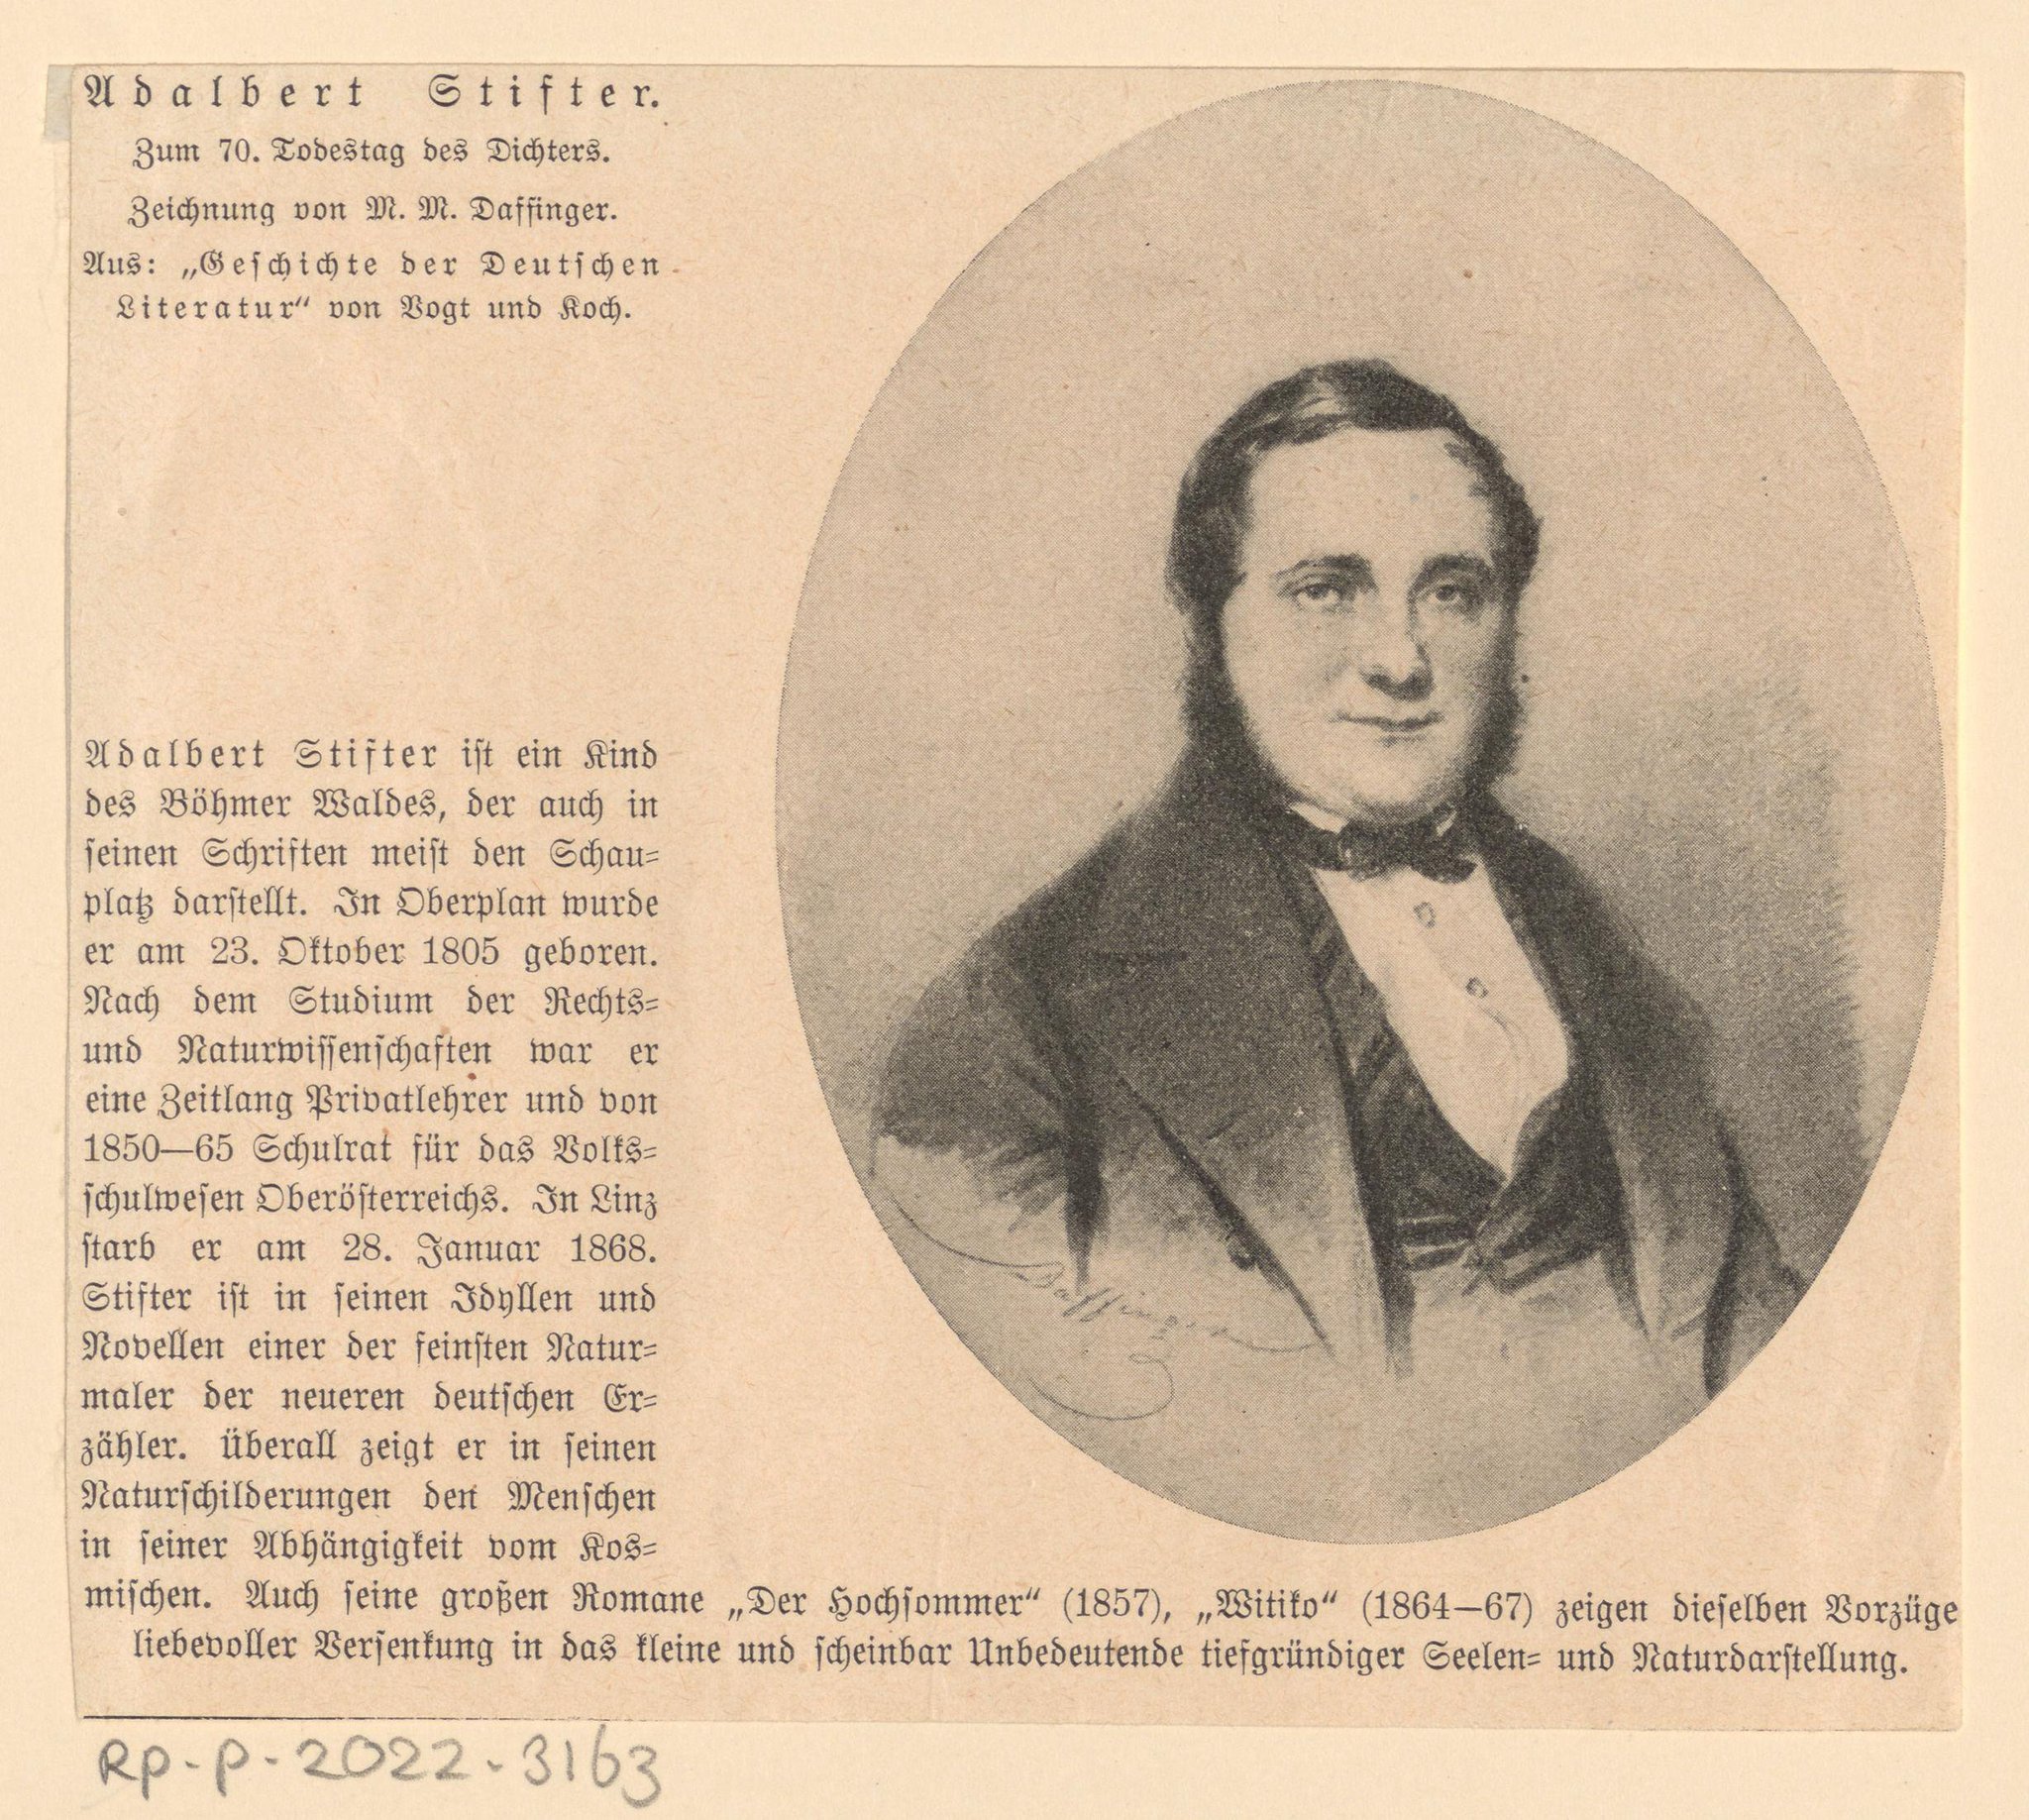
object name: photomechanical print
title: Portret van Adalbert Stifter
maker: Anonymous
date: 1882-1970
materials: paper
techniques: letterpress printing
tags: painter, historical persons, portrait of a writer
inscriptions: stamp: ‘JVB’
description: Fotomechanische afdruk uit een onbekende publicatie.